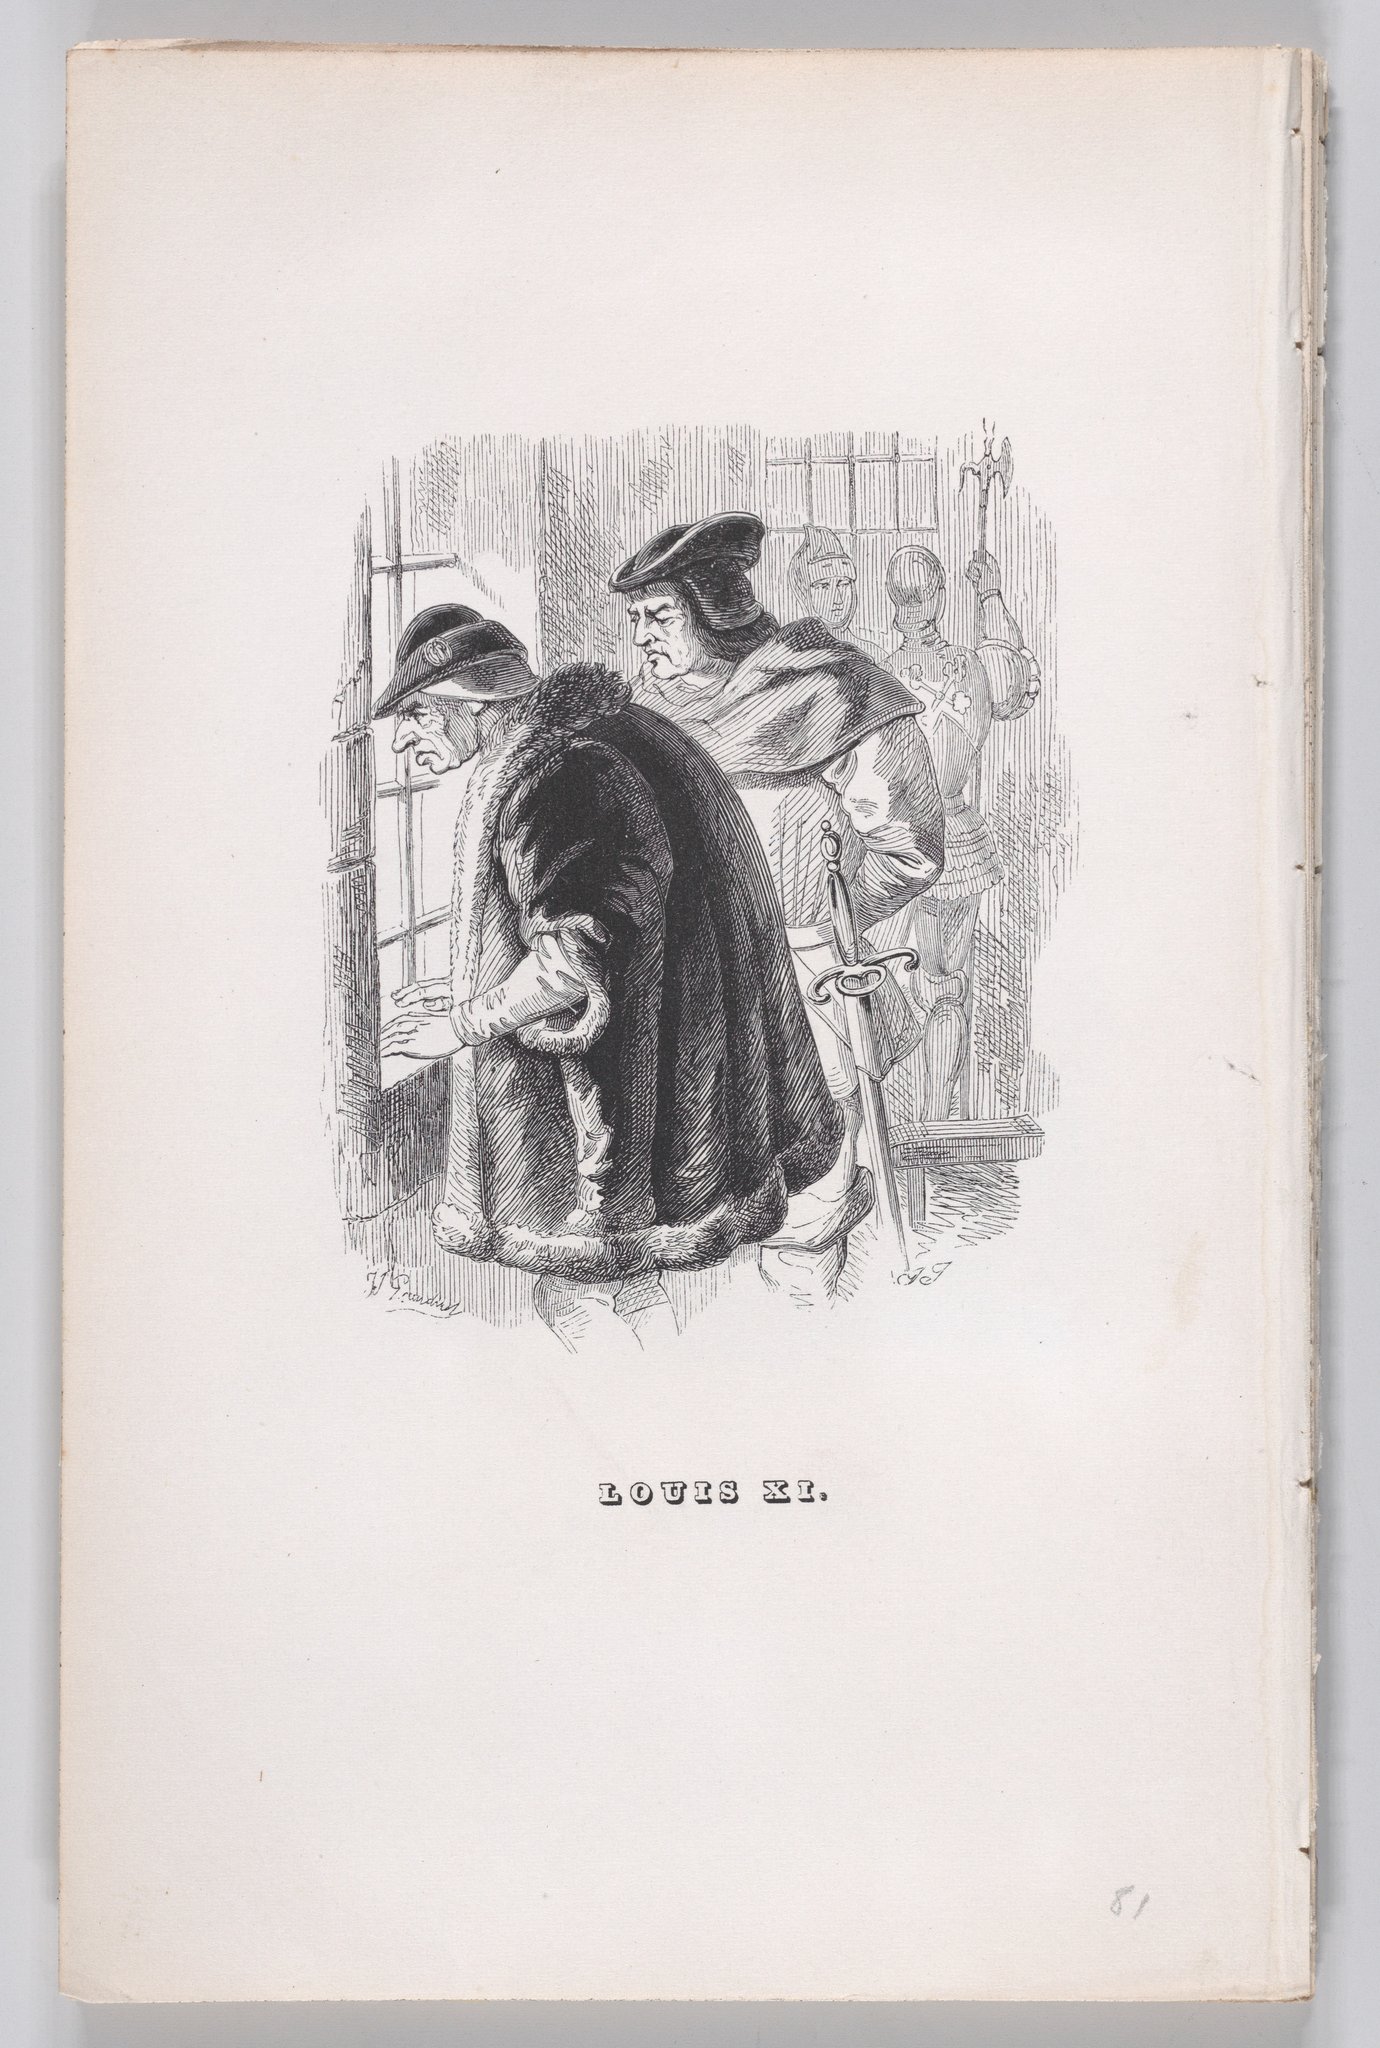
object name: print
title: Louis XI, from "The Complete Works of Béranger"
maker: j. j. grandville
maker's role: illustrator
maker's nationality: french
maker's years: 1803-1847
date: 1836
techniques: engraving